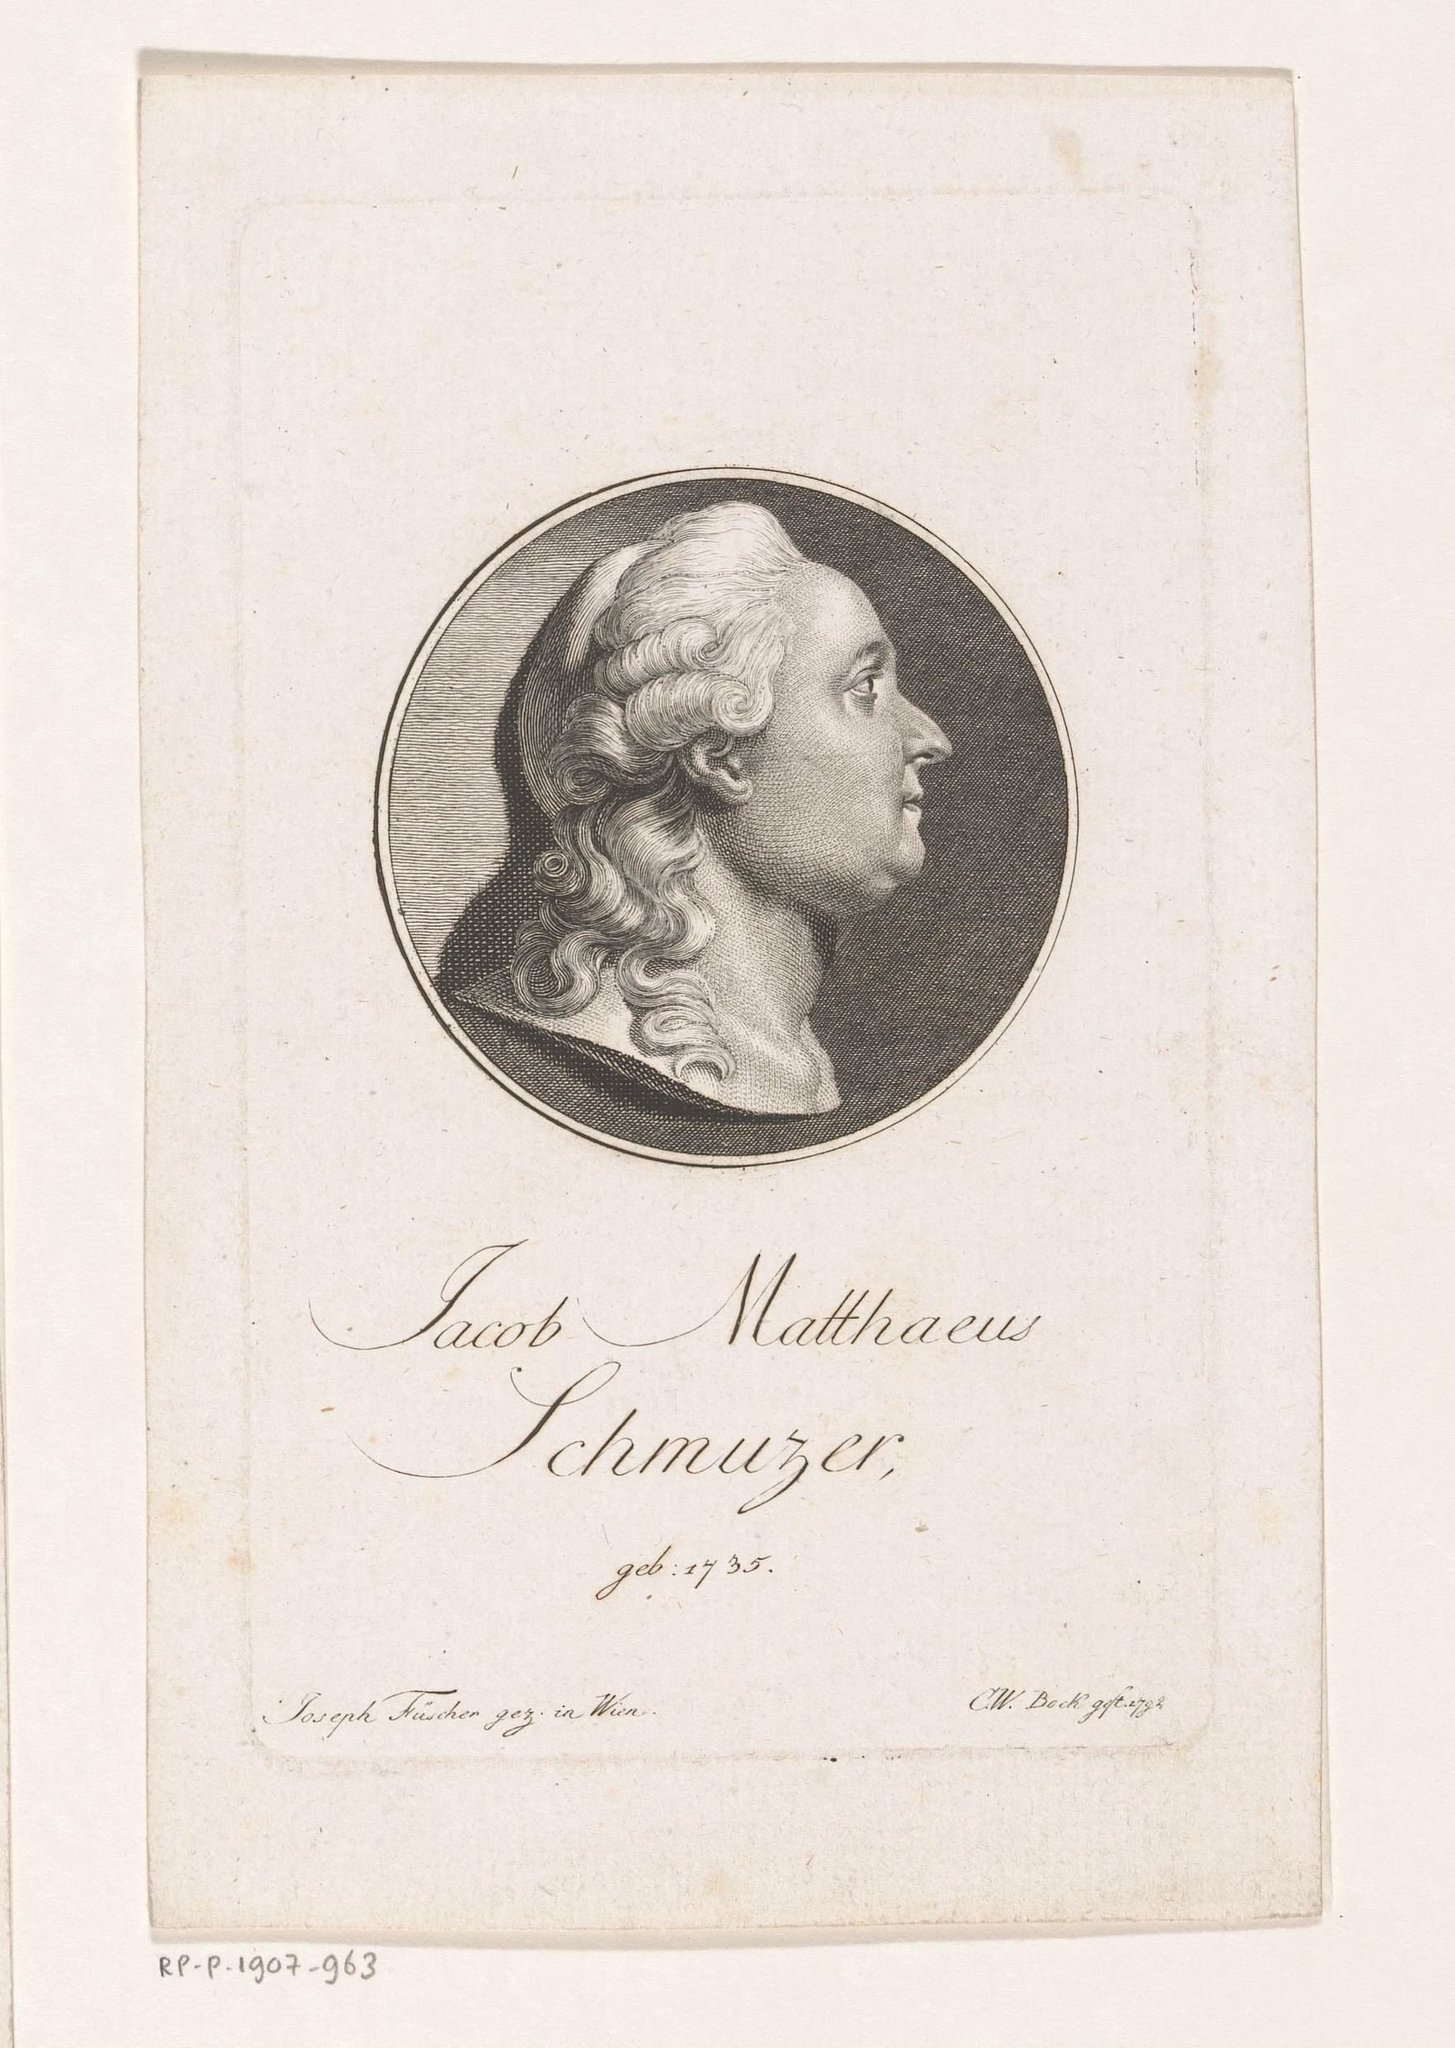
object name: print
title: Portret van Jakob Matthias Schmutzer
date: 1792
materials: paper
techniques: engraving, etching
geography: vienna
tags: vienna, jakob matthias schmutzer, portrait, self-portrait of graphic artist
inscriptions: collector's mark: Lugt 2228